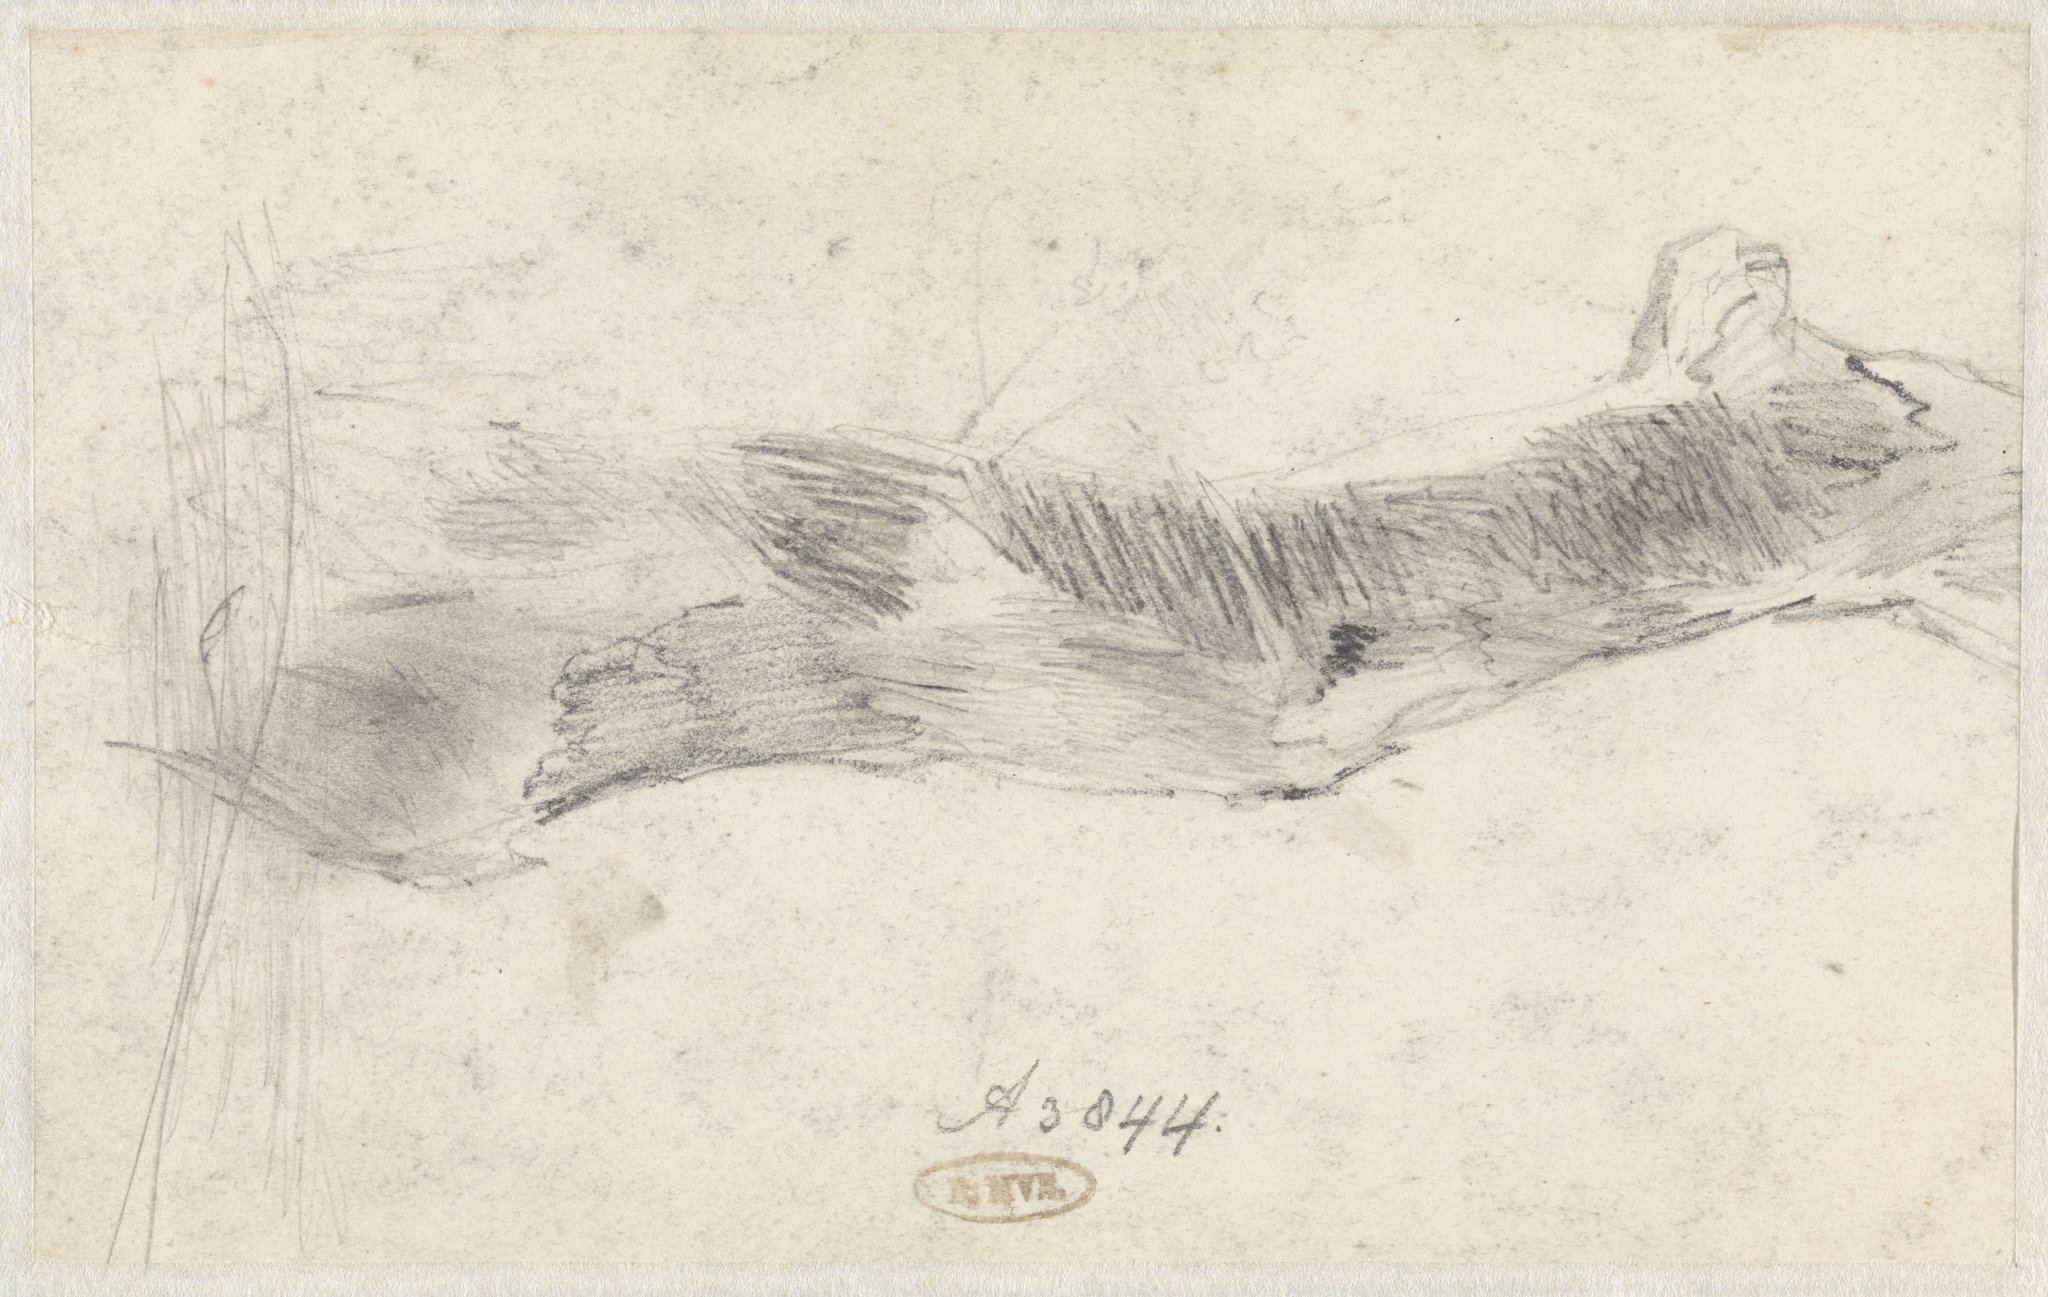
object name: drawing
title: Studie van een boom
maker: willem anthonie van deventer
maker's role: draughtsman, painter, print maker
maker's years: 1824-1893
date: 1834-1893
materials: chalk, paper, pencil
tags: trees